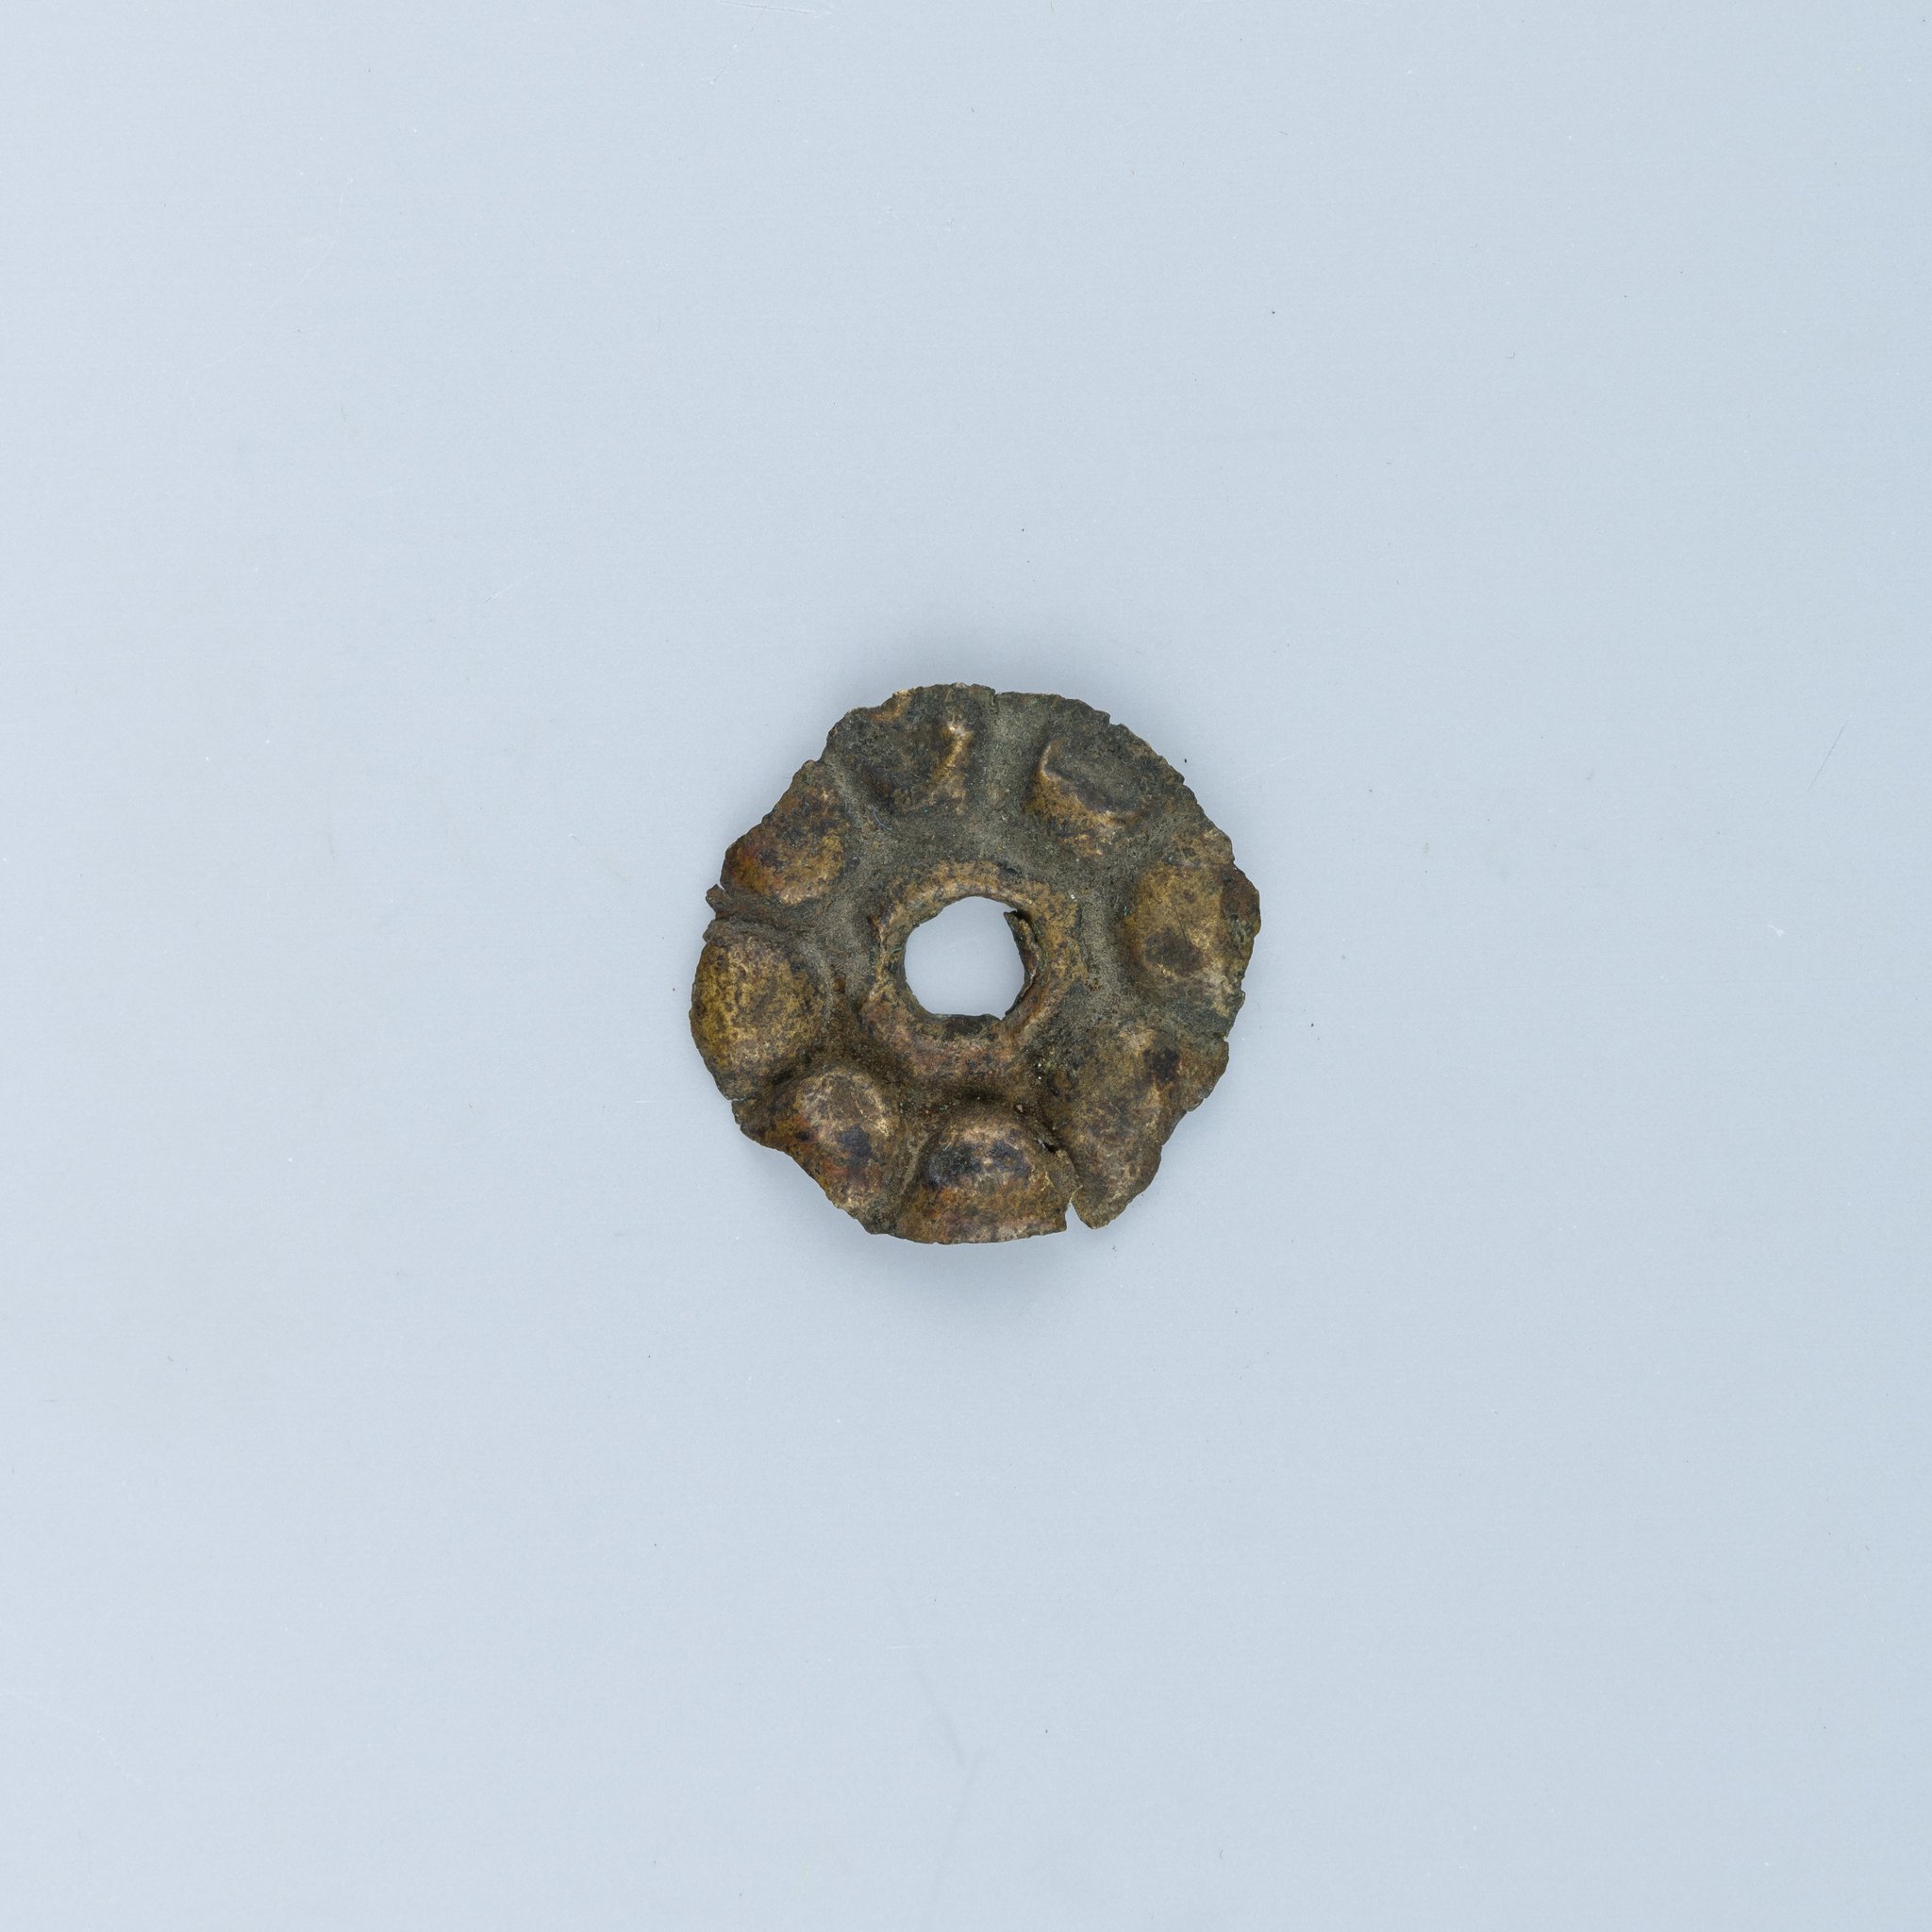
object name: rosette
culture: italian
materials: brass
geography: italy